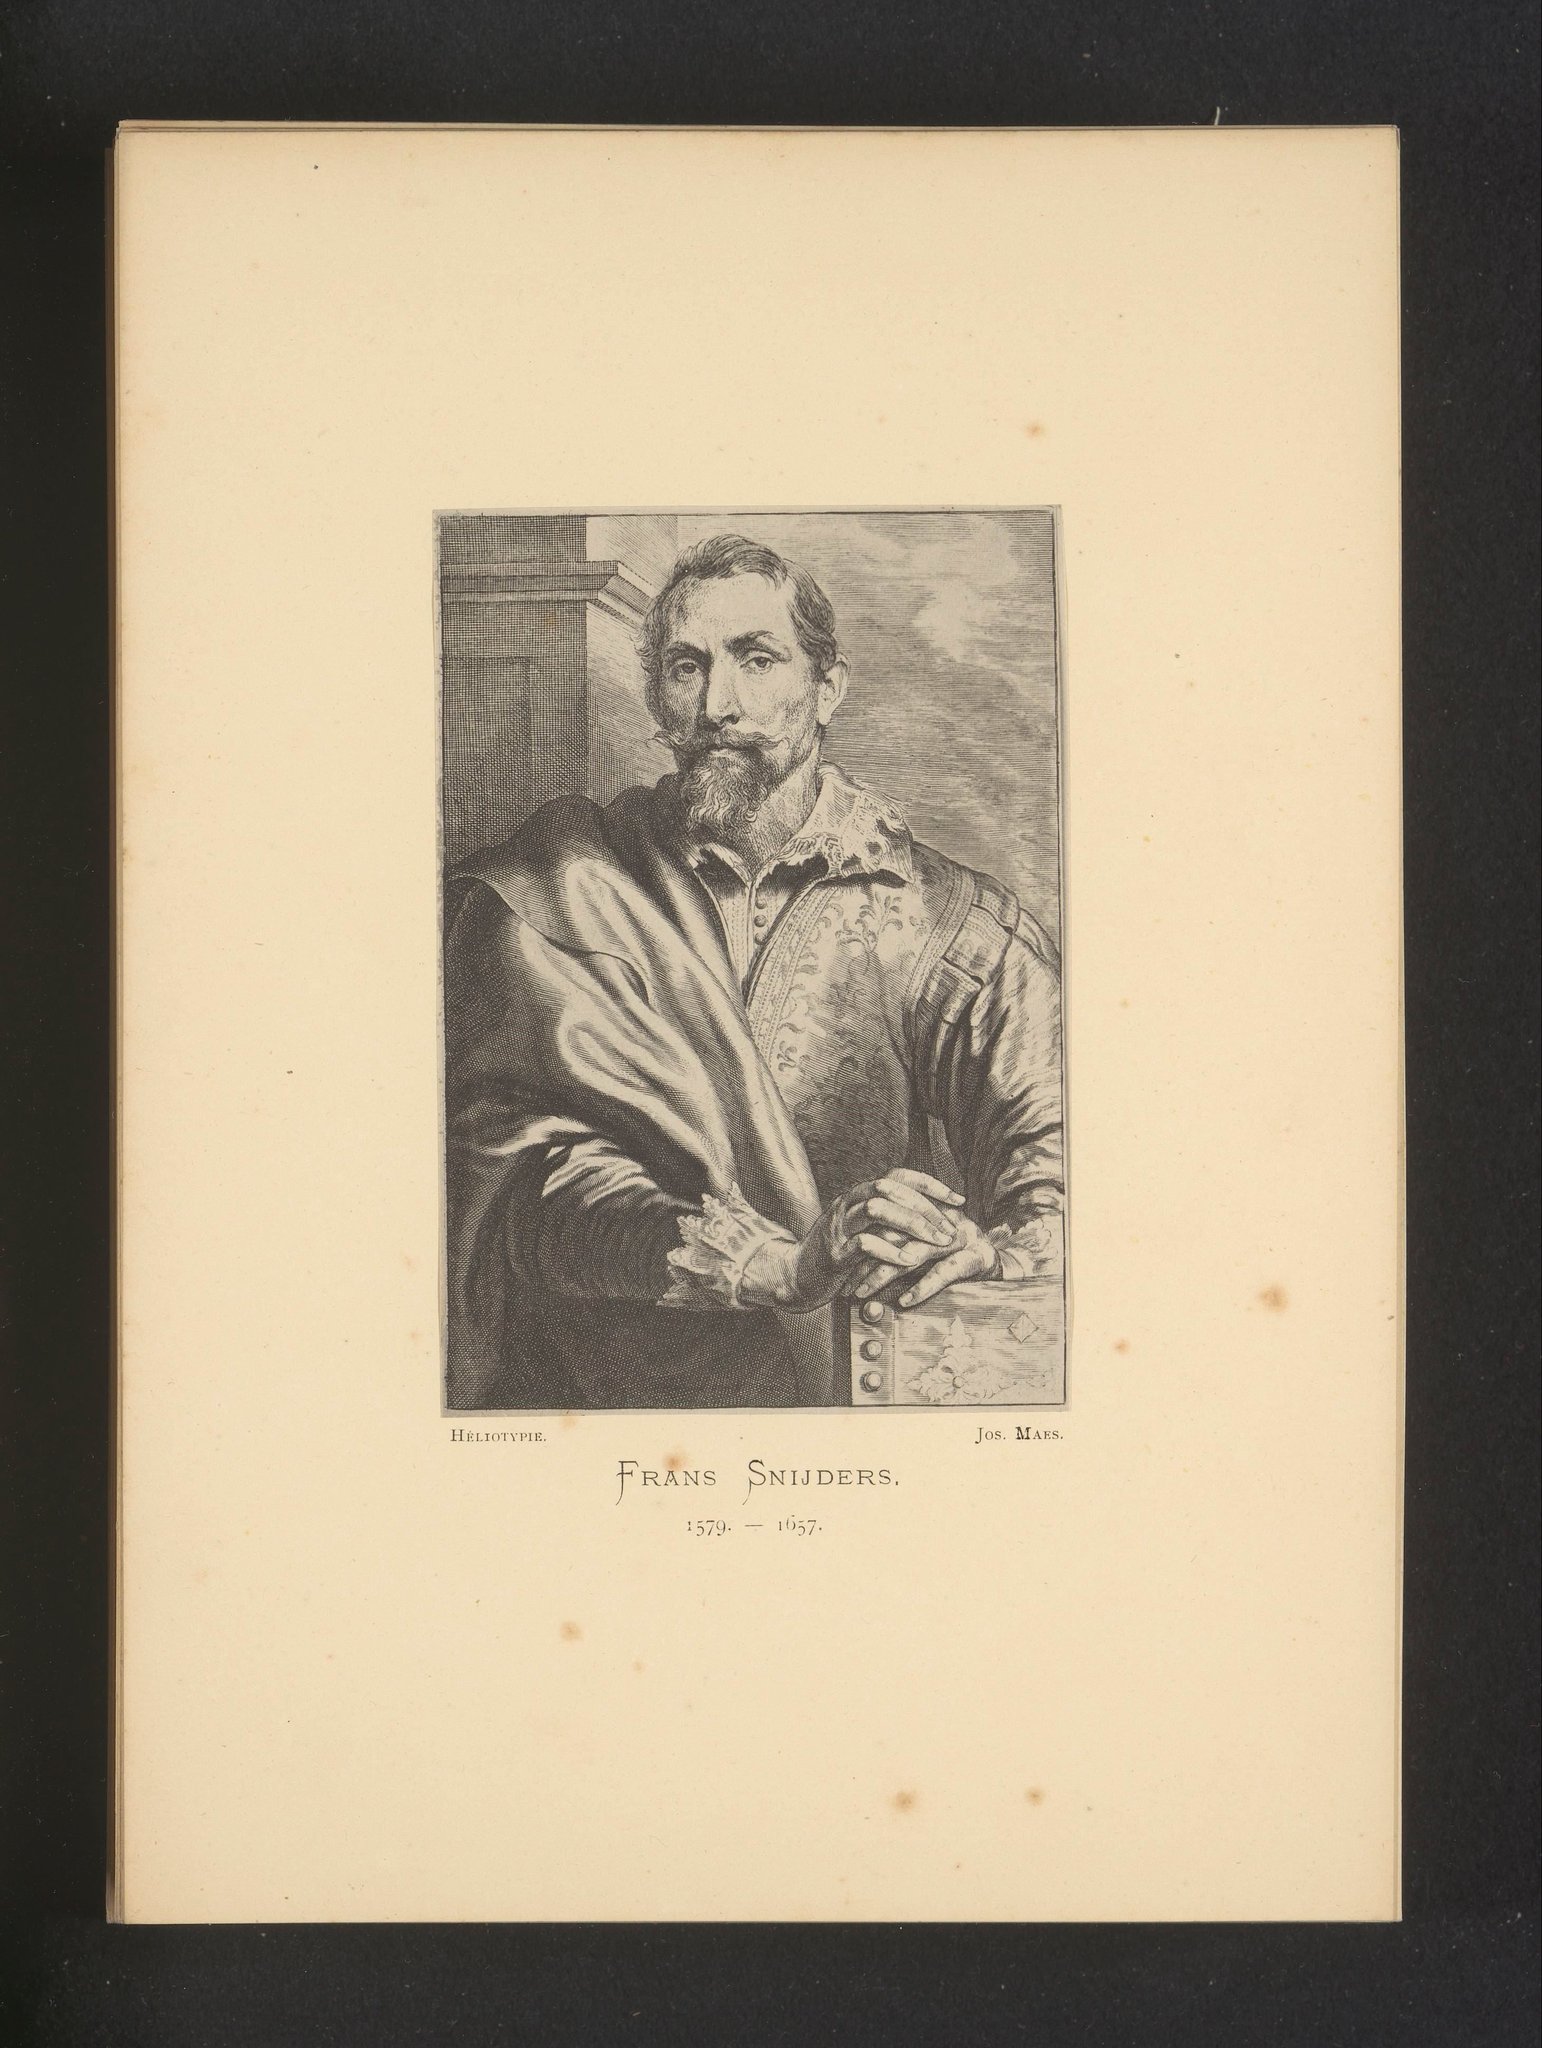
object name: photomechanical print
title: Reproductie van een gravure van een portret van Marten Pepijn door Anthony van Dyck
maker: joseph maes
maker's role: fotograaf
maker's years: 1838-1908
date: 1872-1877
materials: cardboard, paper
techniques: photograph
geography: antwerp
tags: antwerp, painter, draughtsman, frans snijders, historical persons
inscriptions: inscription: ‘1579. - 1657.’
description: Deze prent maakt deel uit van een omslag met 150 prenten en een katern met een lijst van afbeeldingen.